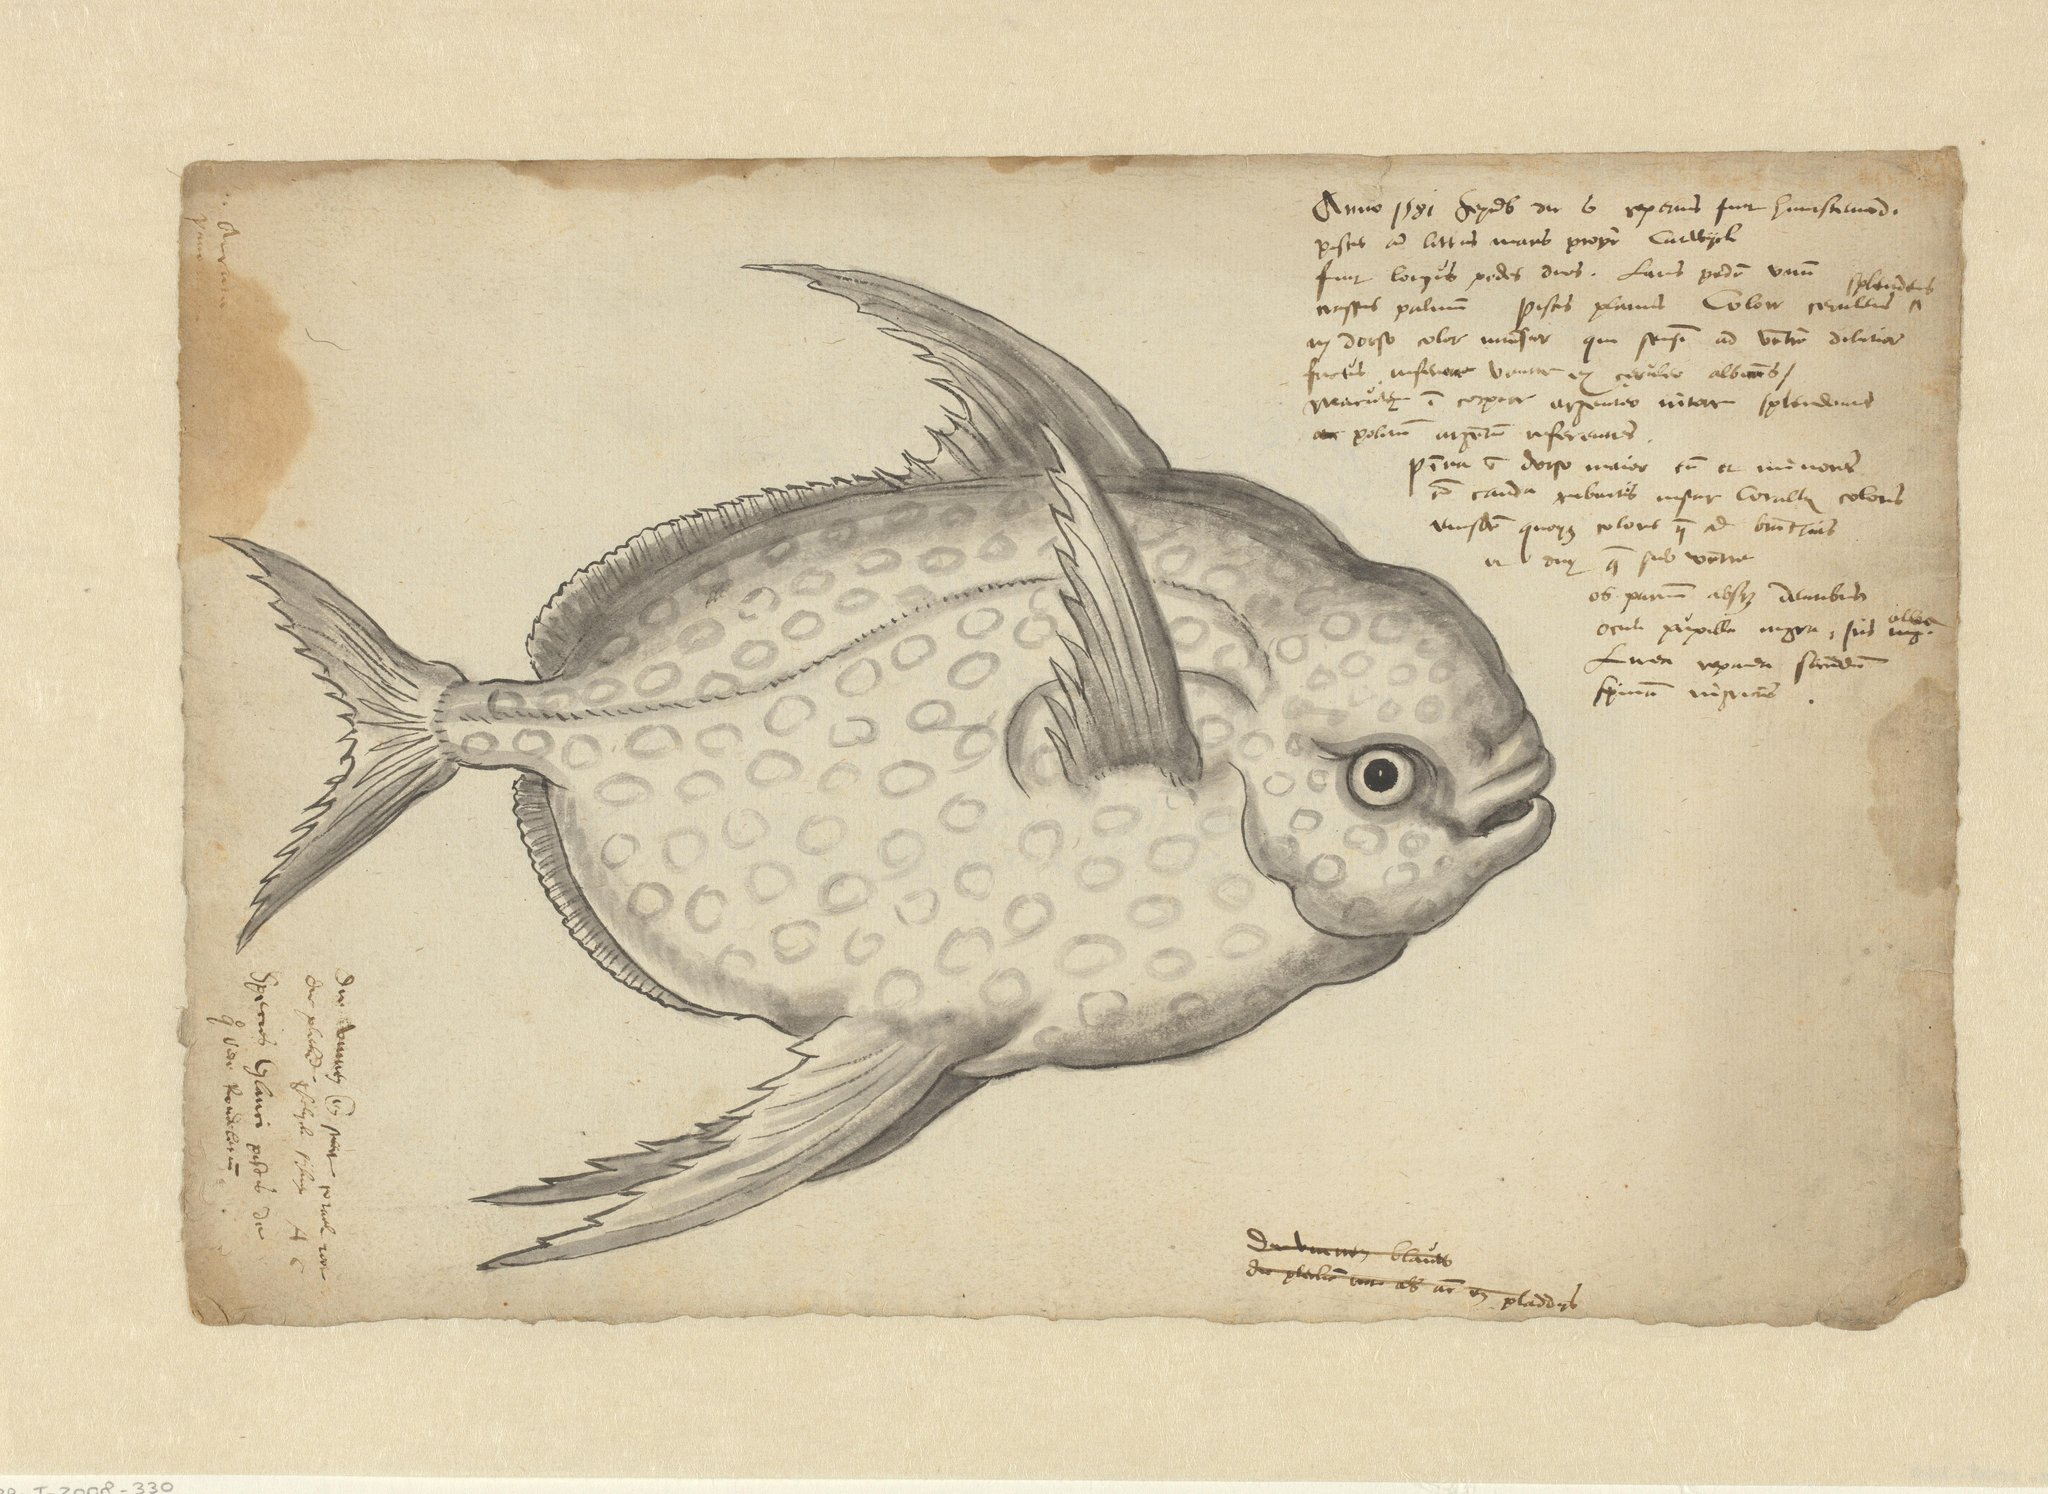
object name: drawing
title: Kingfish (Lampris guttatus)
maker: adriaen coenen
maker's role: draughtsman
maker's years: 1514-1587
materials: ink, paper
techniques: brush, pen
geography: netherlands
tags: fishes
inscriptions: inscription: ‘Die vinnen blauw/ die pleckē wit als aē een pladdijs’, inscription: ‘Anno 1581 Septeb die 6 repertus fuit hujuscemodo/ piscis ad littus maris prope Catwijck/ fuit longus pedes duos. Latus pede unu/ crassus palma. Piscis planus. Color ceruleus splendens/ in dorso color intensior qui sensī ad vētrē dilutior/ factus inferiore ventre ex ceruleo albens/ Maculae ī corpore argenteo nitore splendentes/ ac politū argētē referentes/ Pina ī dorso maior cū et minores/ tū cauda rubentes/ instar coralli coloris/ eiusdē quoque coloris ǭ ad branchias/ et duae ǭ sub ventre/ os parvū absque dentibus/ oculi pupilla nigra, iris alba/ Linea repanda secūdū/ spinā nigrans’, inscription: ‘Die vinnen ende steert coraal root/ die plecken ghelijck silver A C/ species Glauci piscis de/ quo vide Rondeletiū’